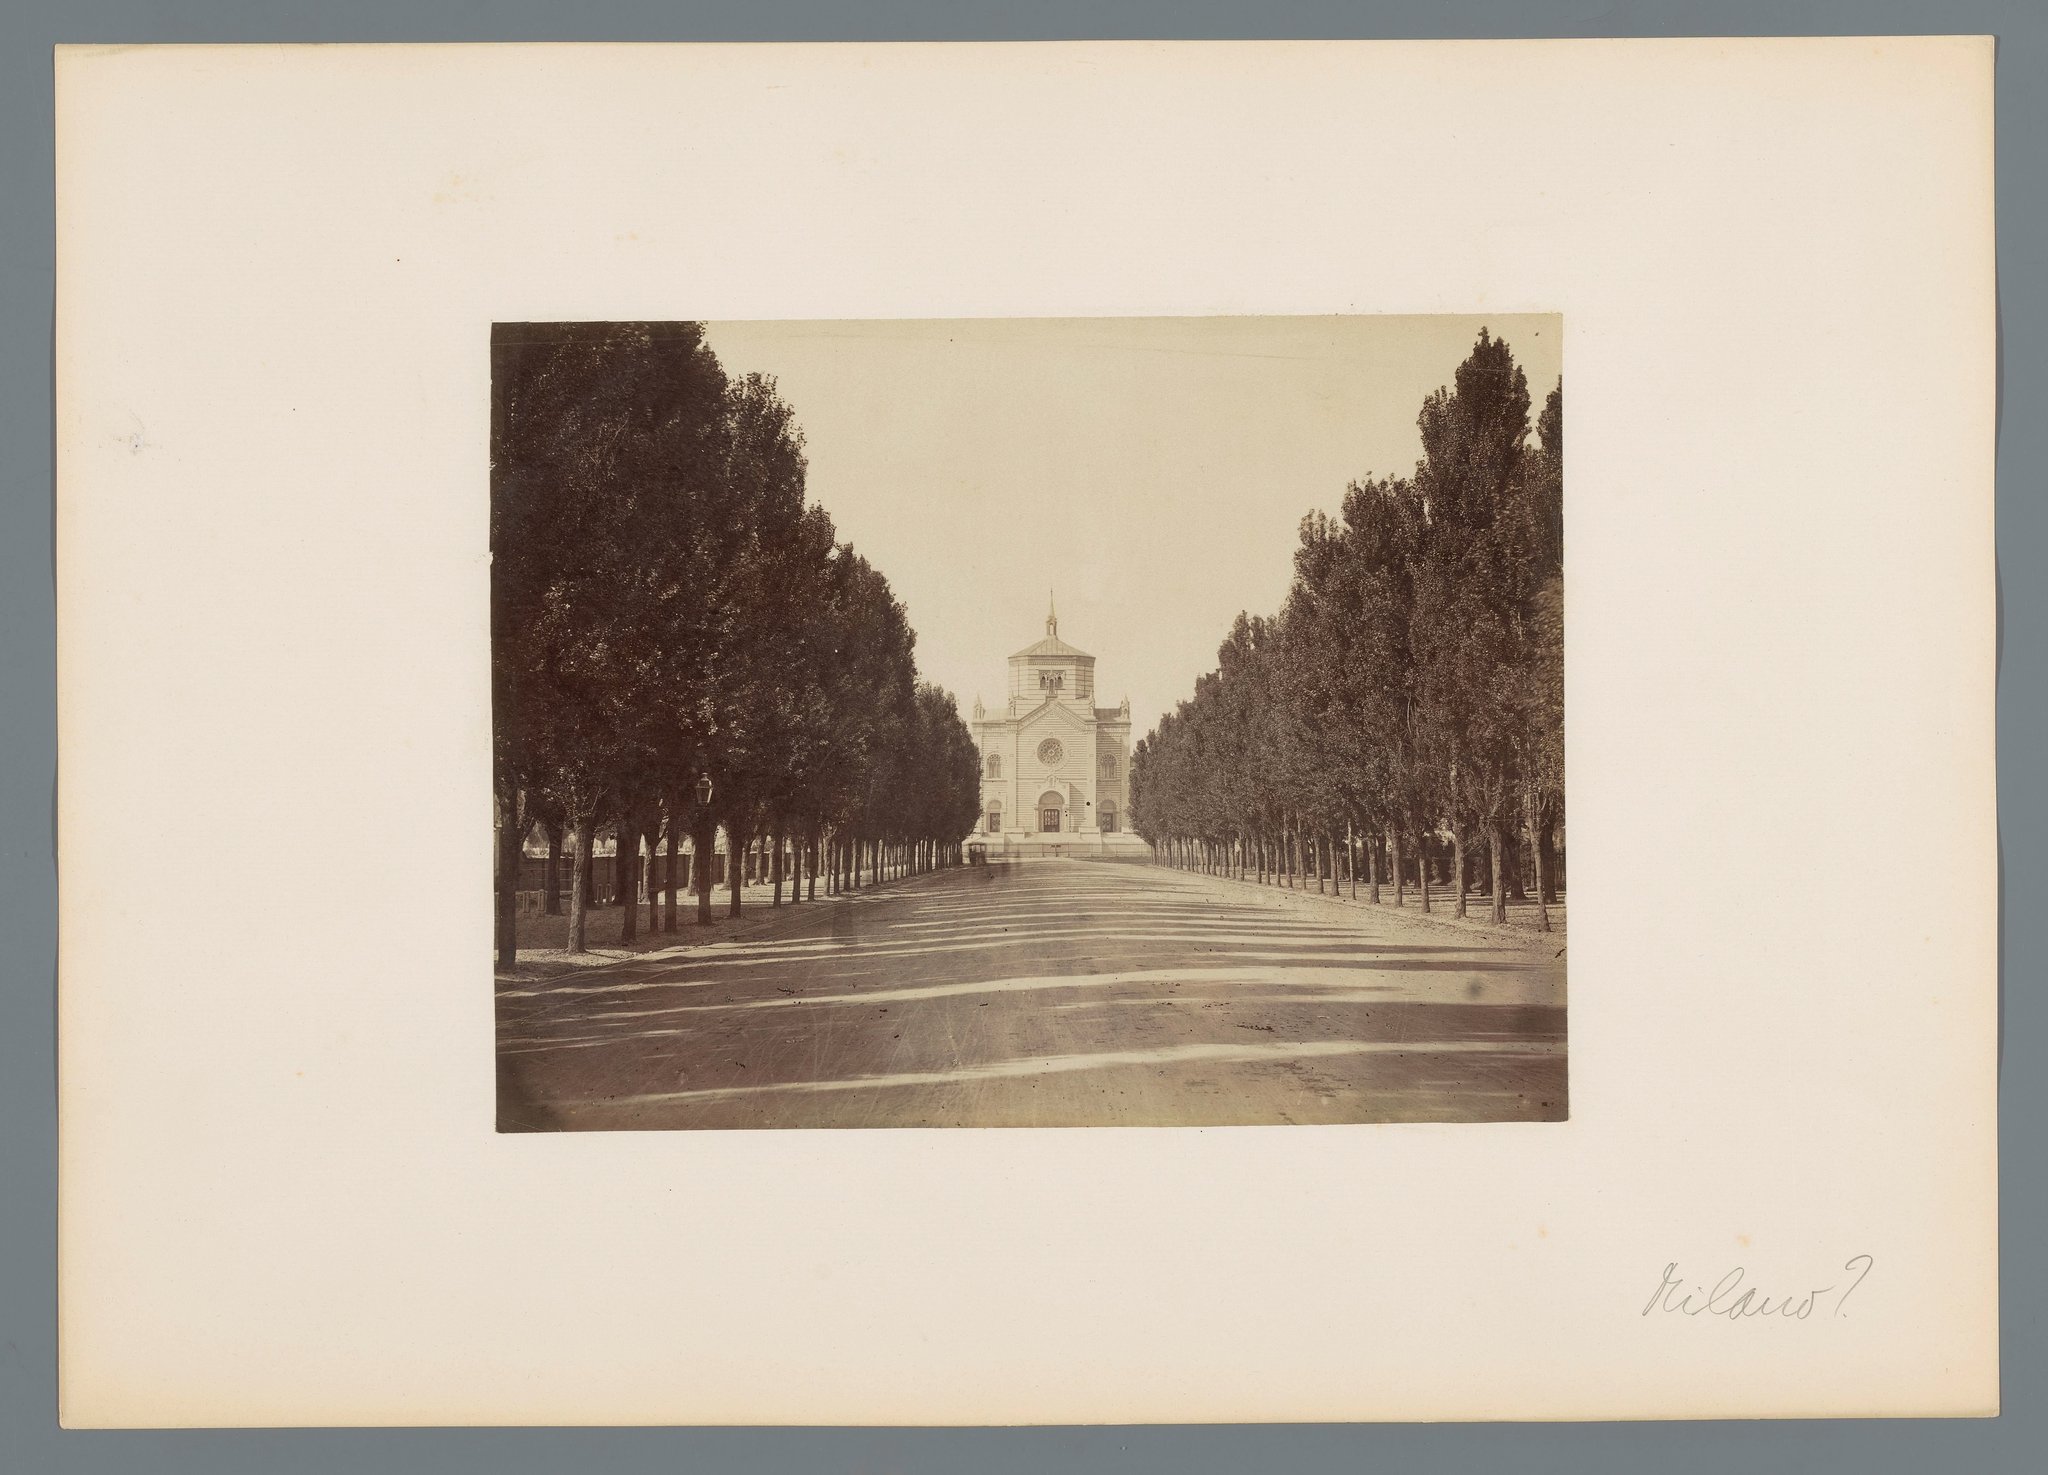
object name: stereograph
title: Gezicht op Parijs met in het midden de Pont Louis-Philippe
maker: Anonymous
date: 1850-1880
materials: cardboard, photographic support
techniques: albumen print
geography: paris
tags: bridge in city across river, canal, etc., prospect of city, town panorama, silhouette of city, paris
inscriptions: inscription: ‘Panorama de Paris’